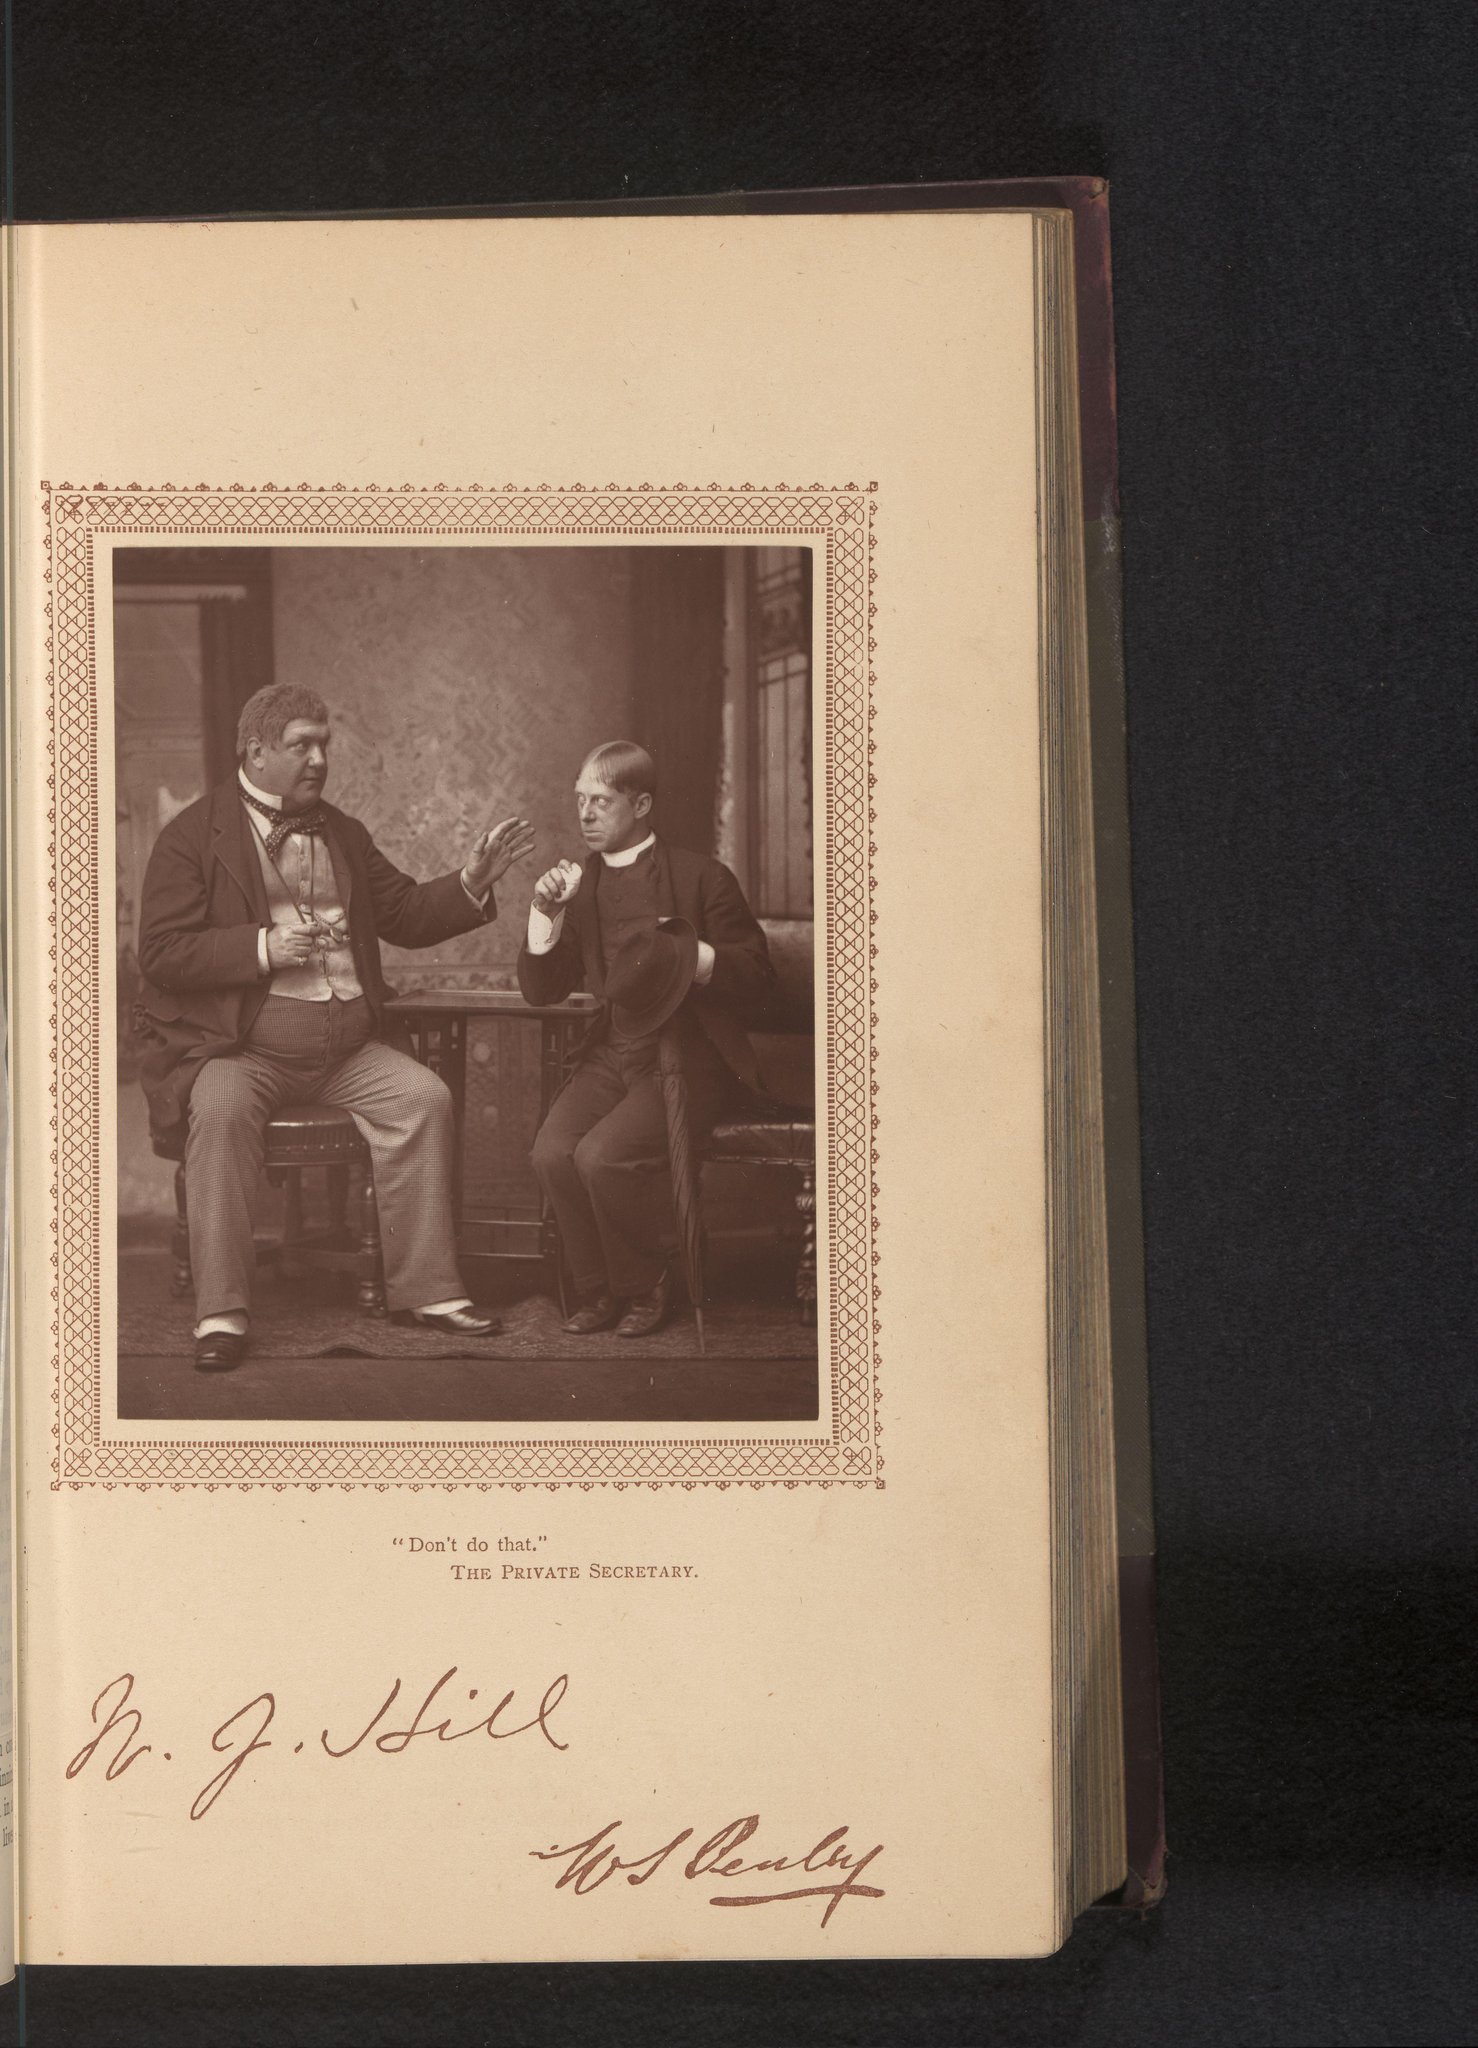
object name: page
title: Portret van W. J. Hill en W. S. Penley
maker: Anonymous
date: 1880-1885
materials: paper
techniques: woodburytype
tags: adult man, historical persons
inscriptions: signature: ‘W. J. Hill/ W. S. Penley’, inscription: ‘'Don't do that.'/ The Private Secretary’